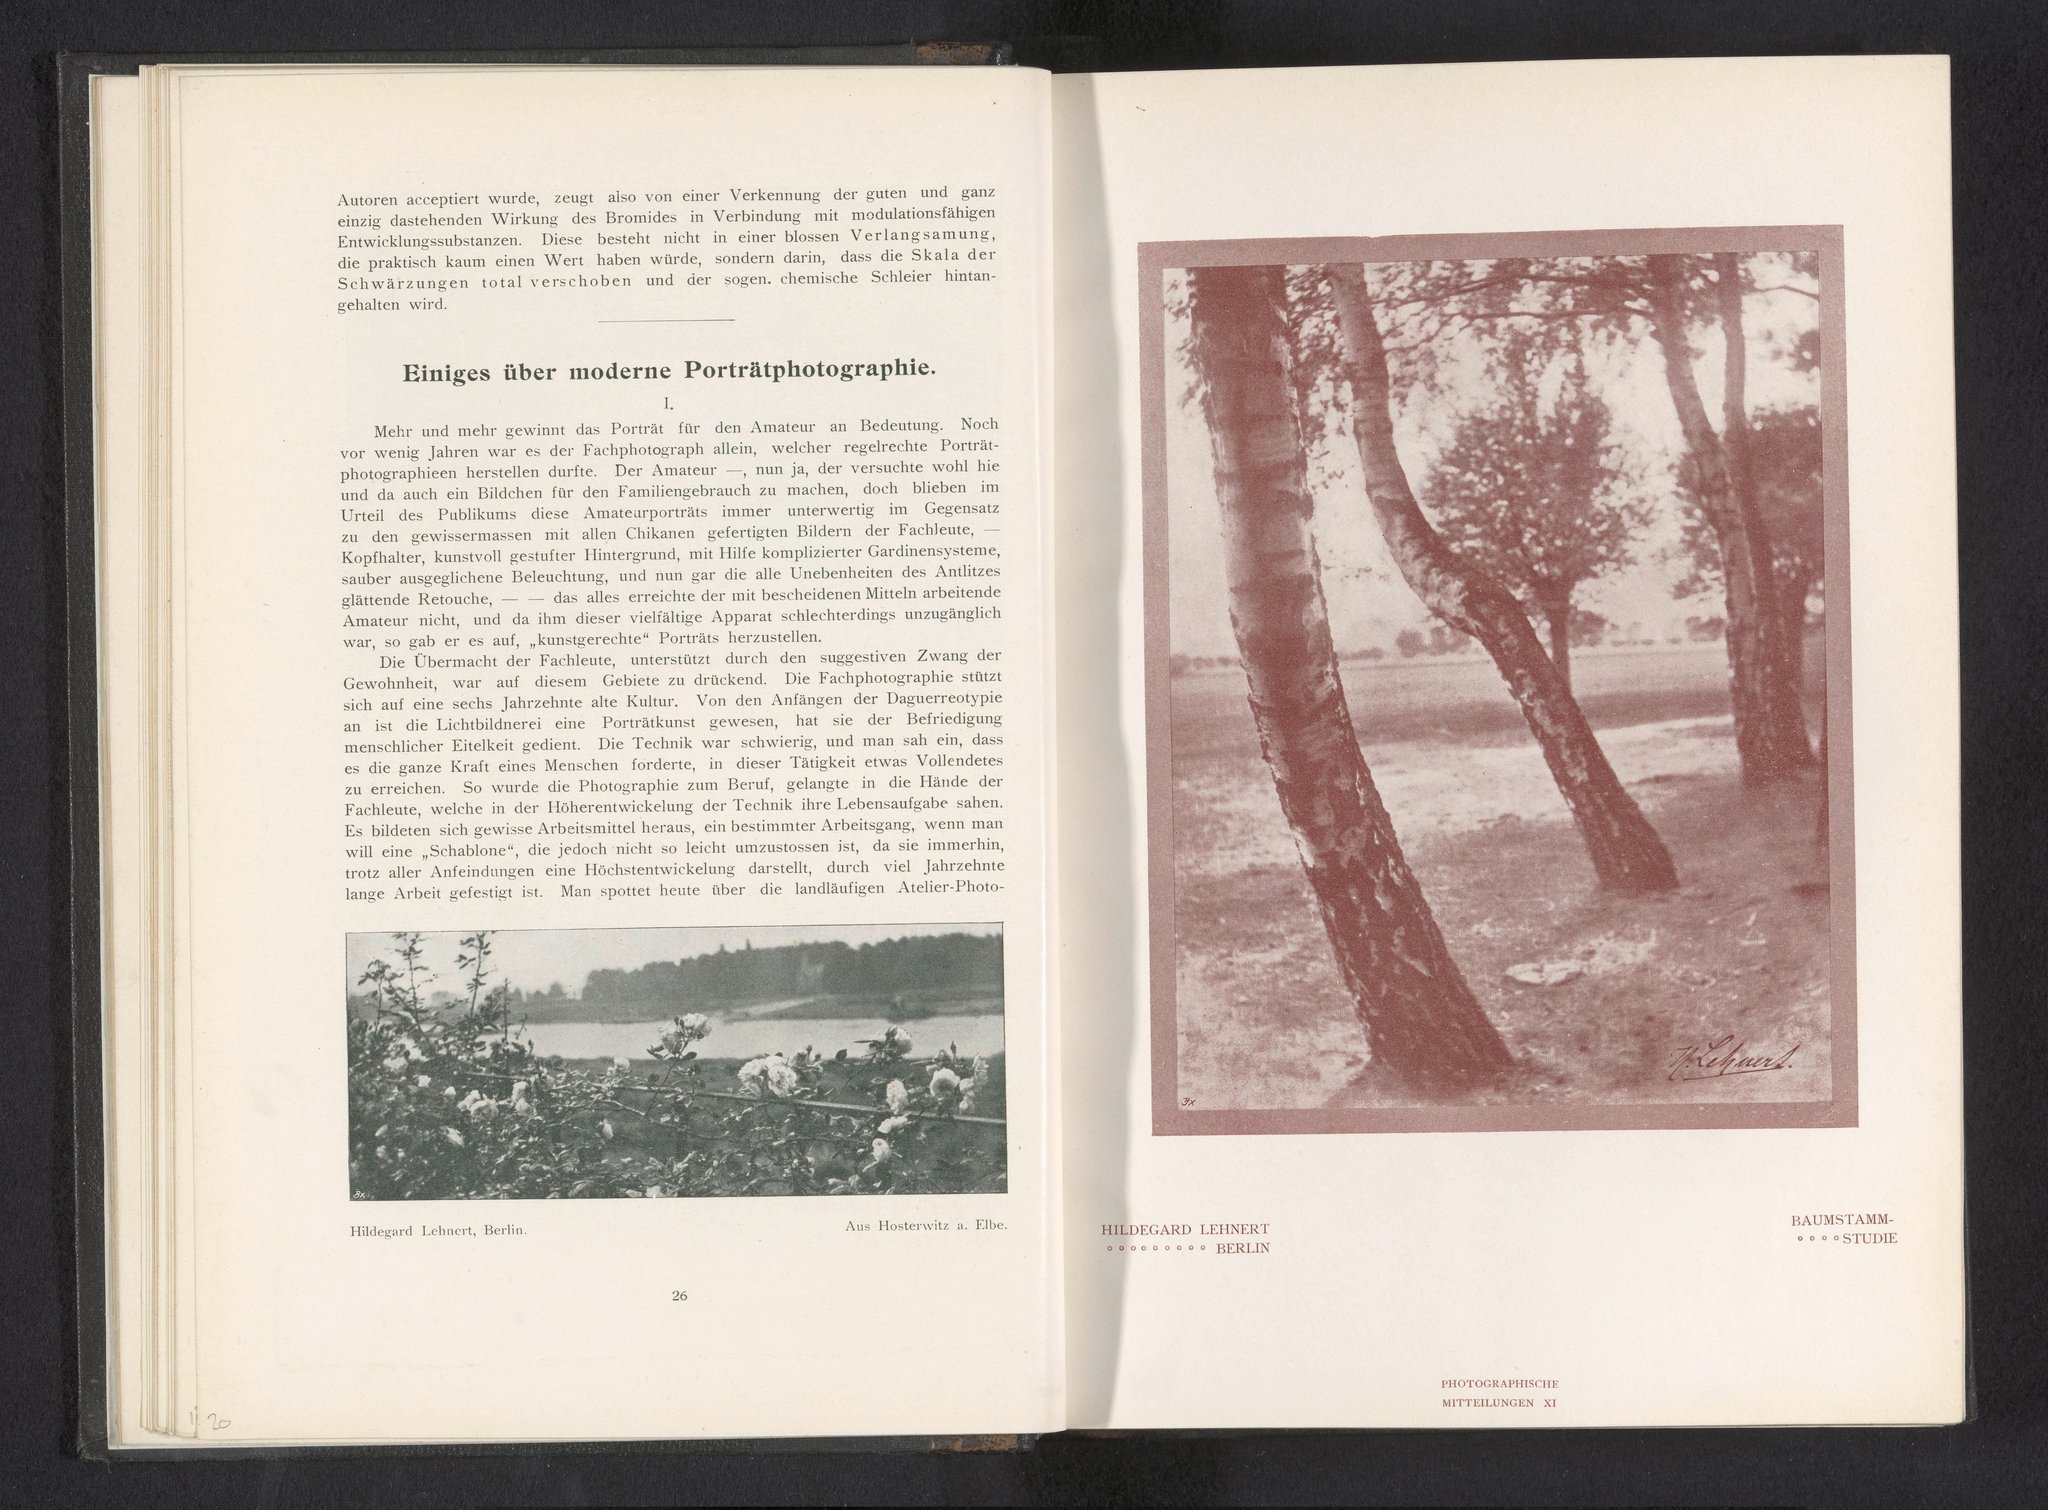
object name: photomechanical print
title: Aus Hosterwitz a. Elbe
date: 1898-1903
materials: paper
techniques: autotype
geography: dresden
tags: city-view in general; 'veduta', river, shrubs: rose-bush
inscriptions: monogram: ‘BX’, inscription: ‘Berlin’